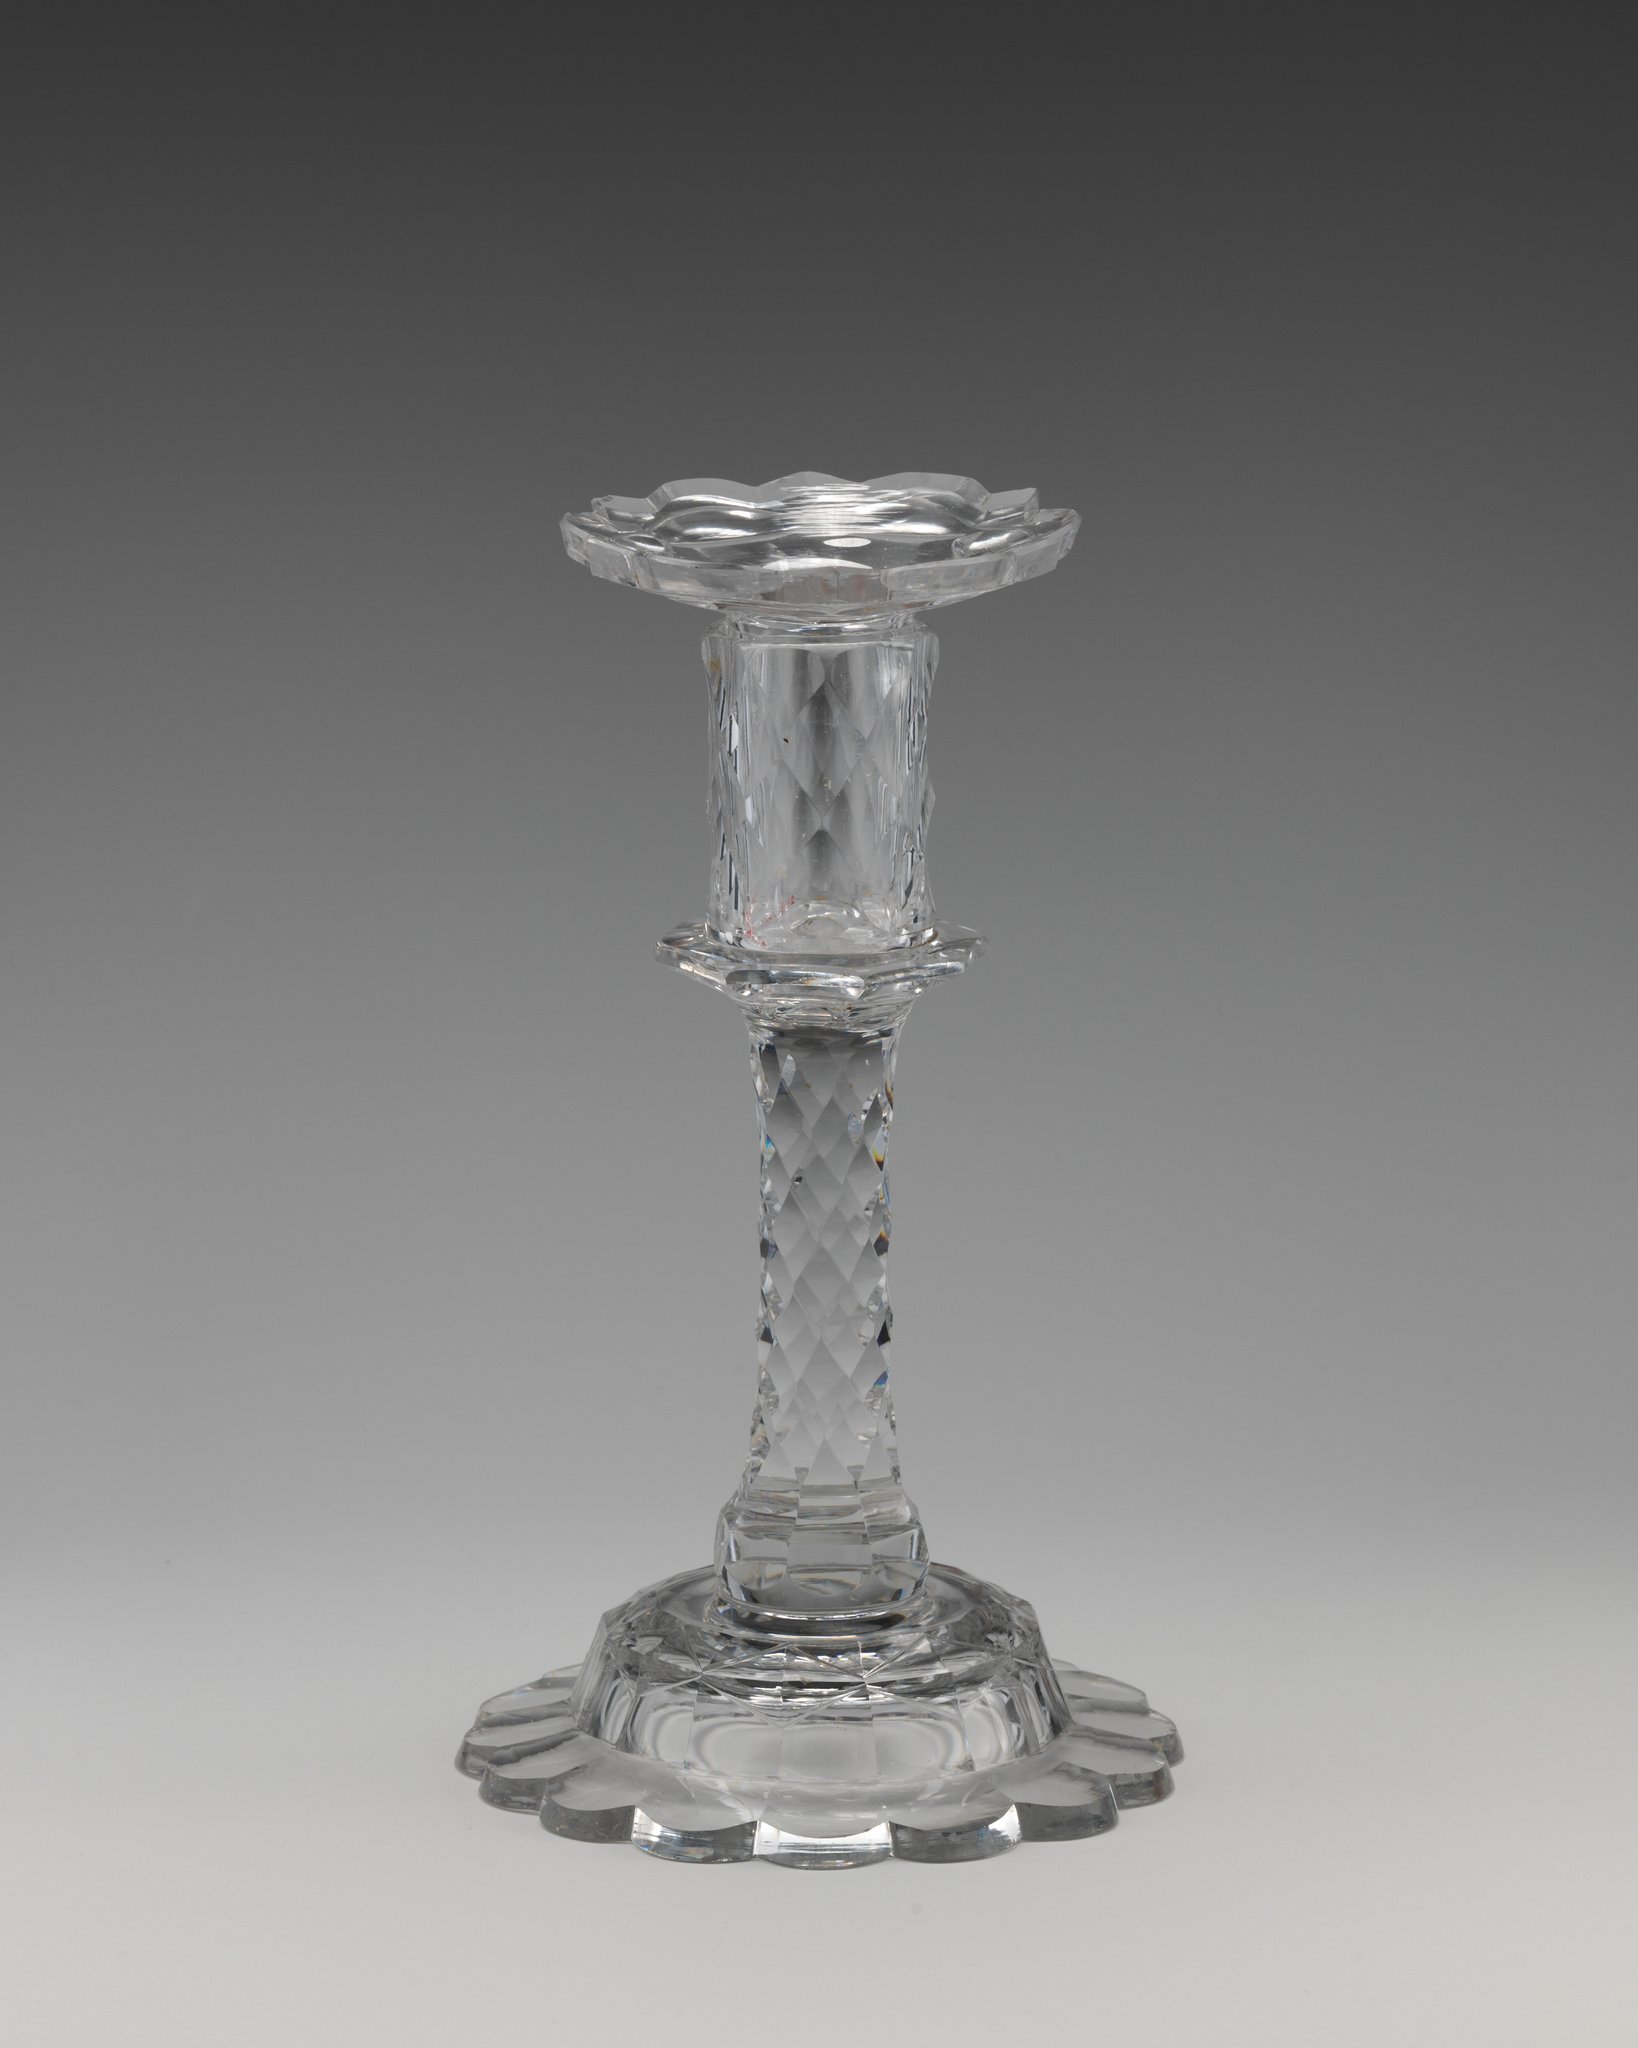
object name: candlestick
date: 1780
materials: glass